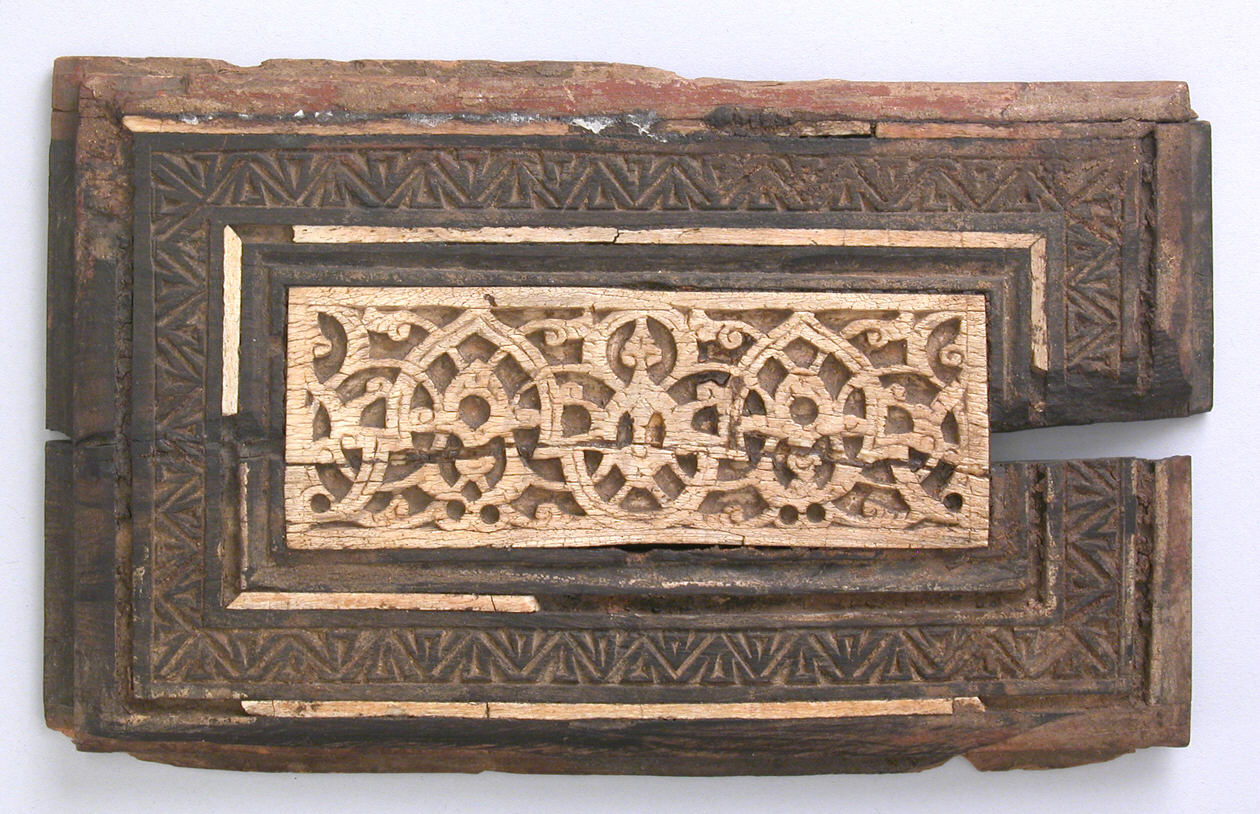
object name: panel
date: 1201-1400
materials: ivory, wood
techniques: carving, inlay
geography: egypt